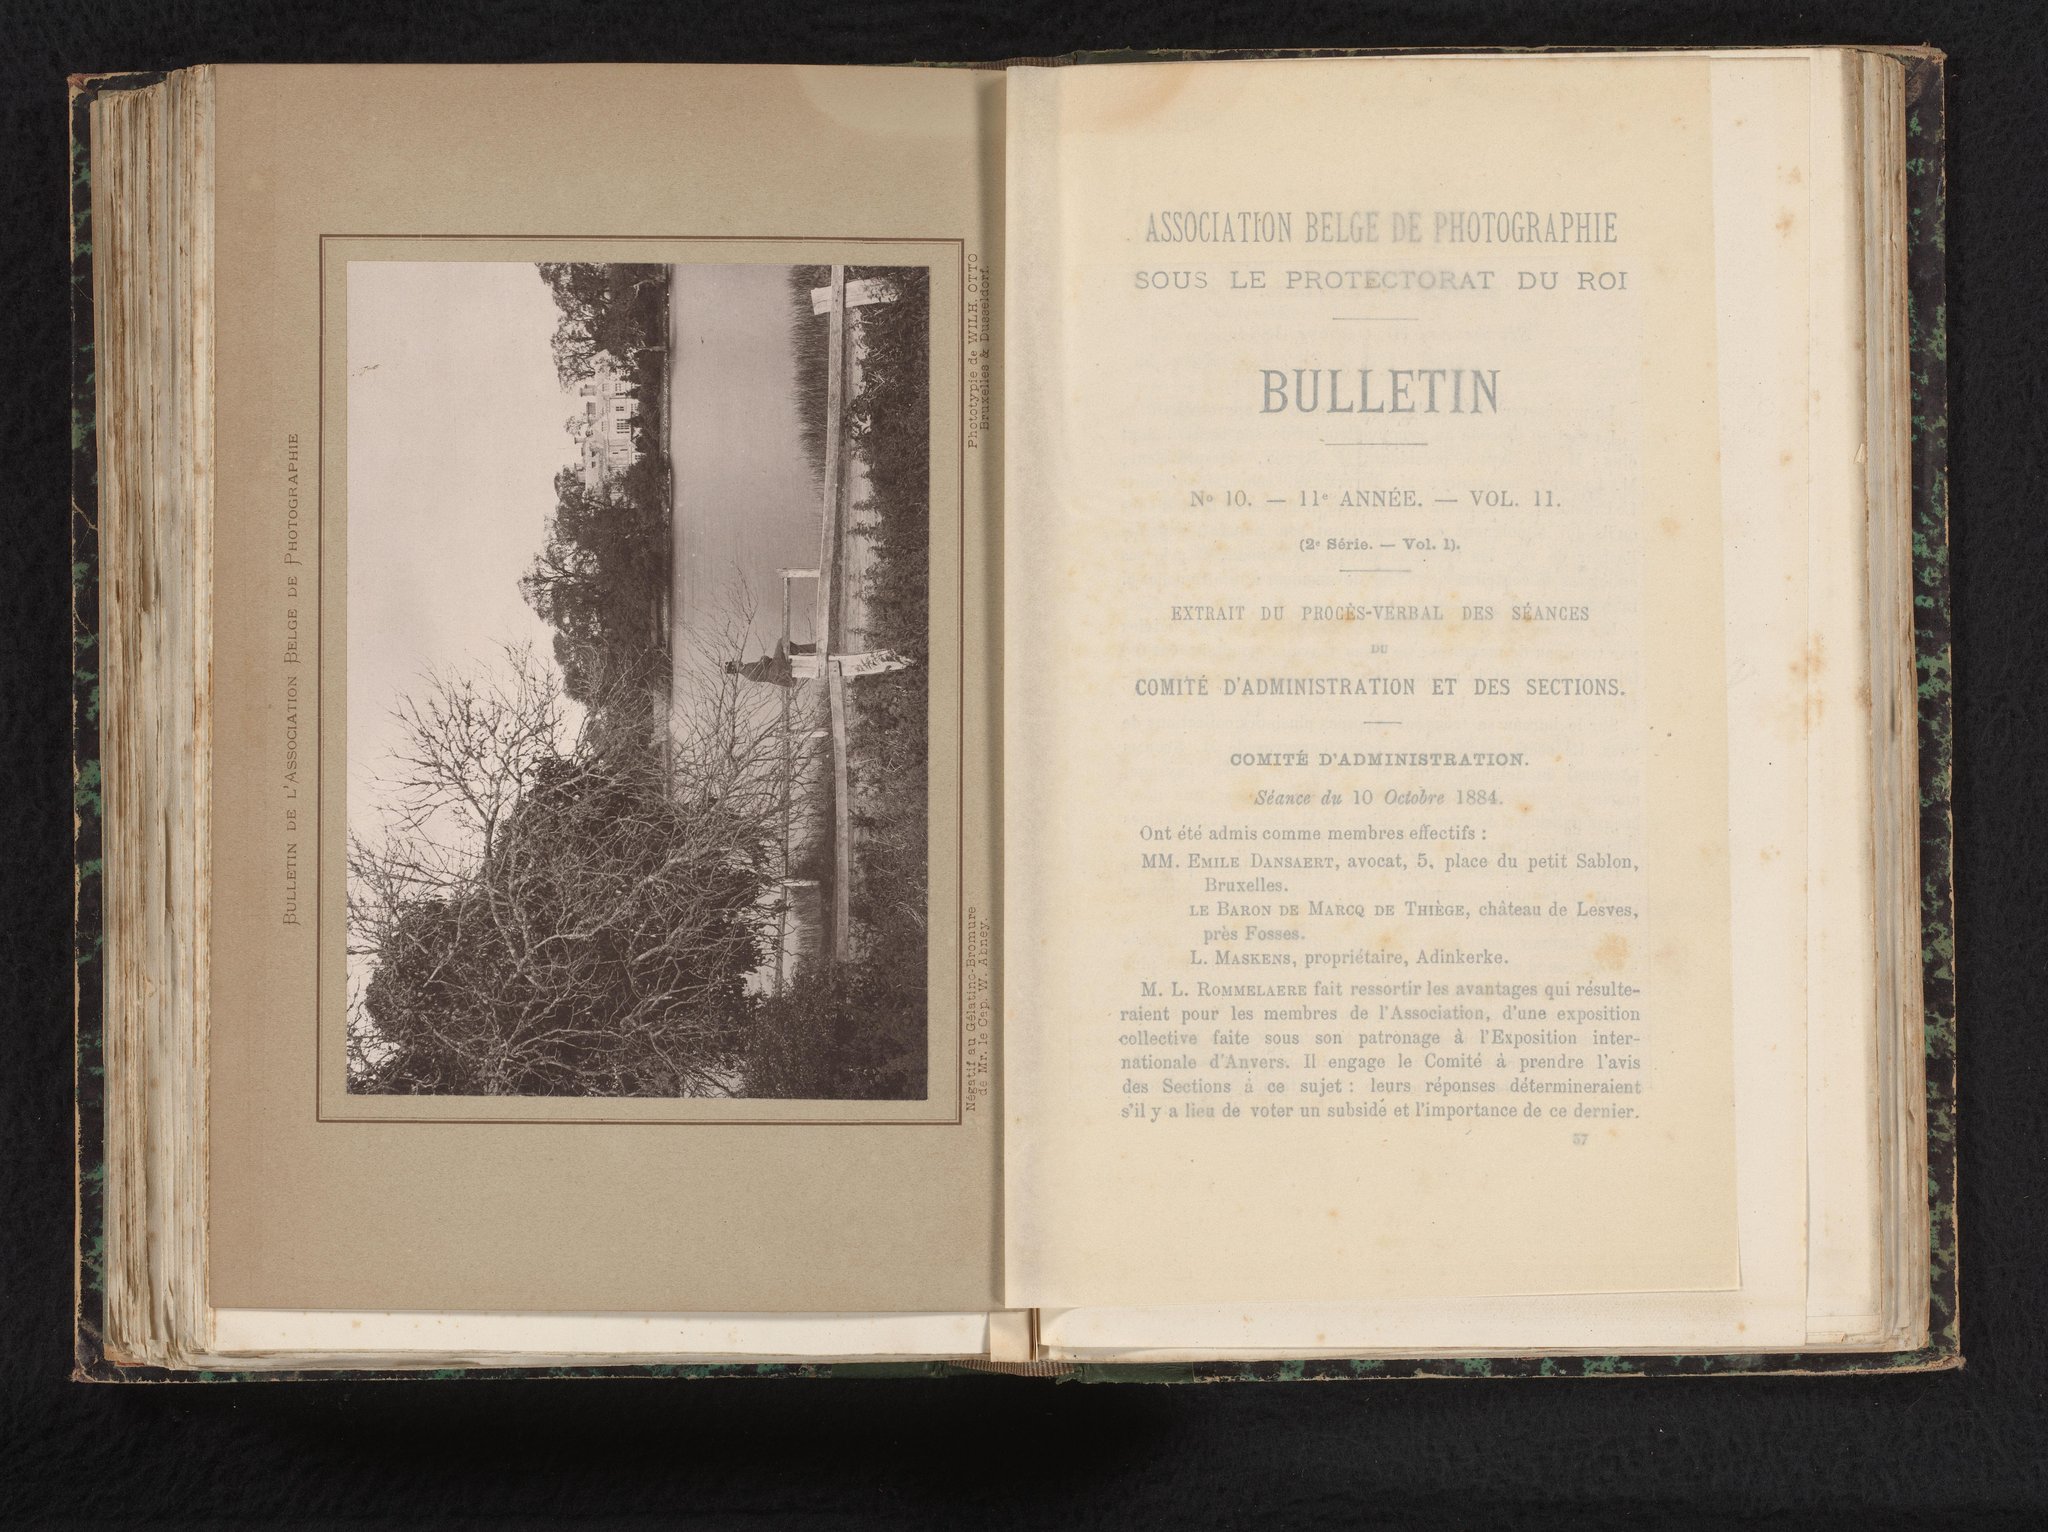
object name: page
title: Man bij een bergmeer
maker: julien bourguignon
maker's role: engineer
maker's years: 1843-1926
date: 1878-1883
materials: paper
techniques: woodburytype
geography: paris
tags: lake, mountains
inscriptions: inscription: ‘Concours de 1883/ Premier prix décerné à M. J. Bourguignon.’